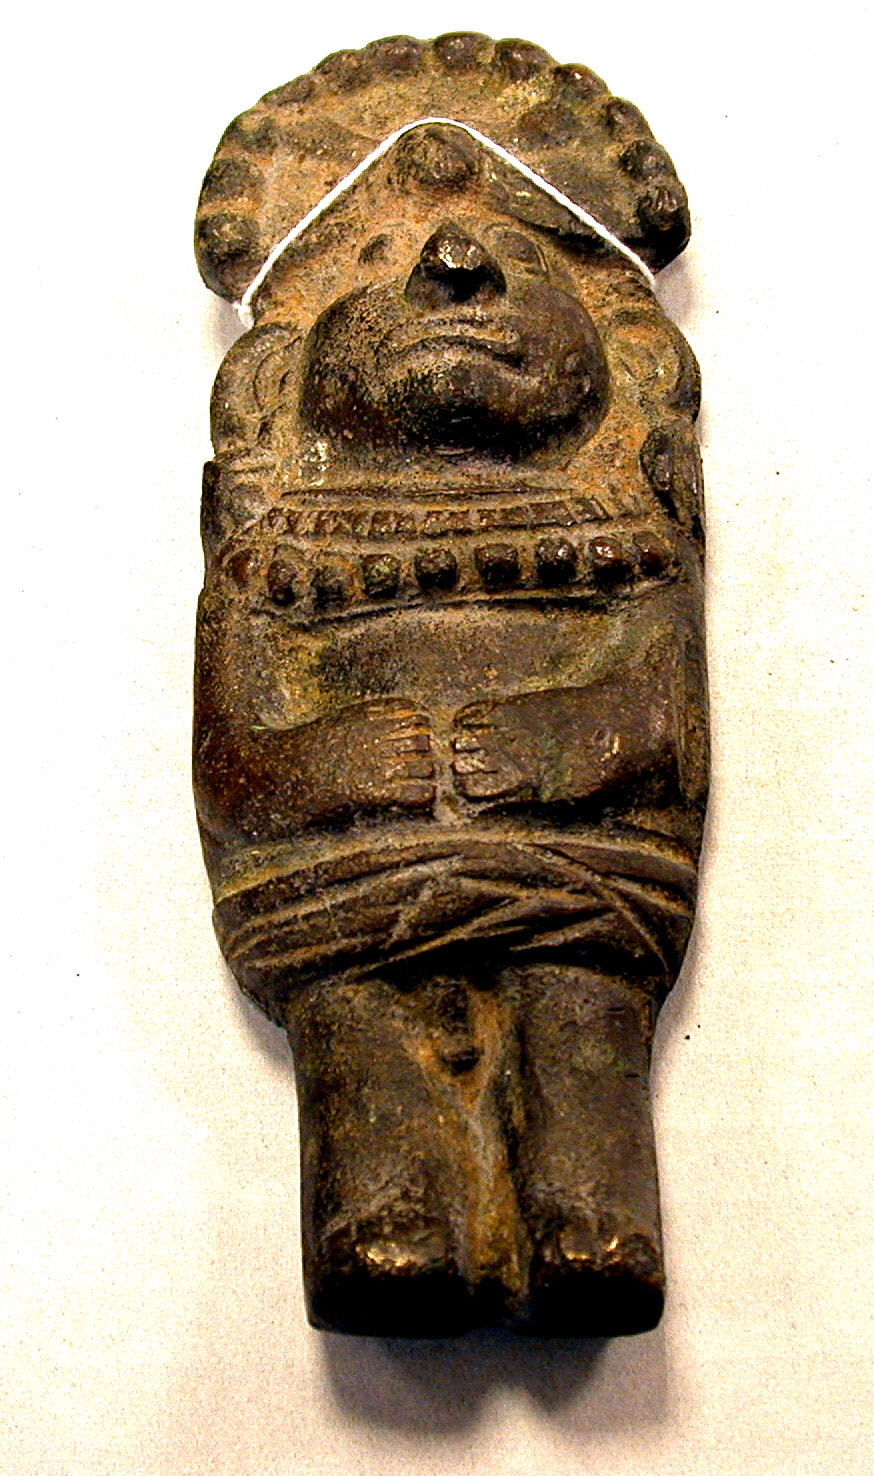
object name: figure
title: Cast Brass Figure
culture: peruvian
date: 1501-1600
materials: brass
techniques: casting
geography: peru